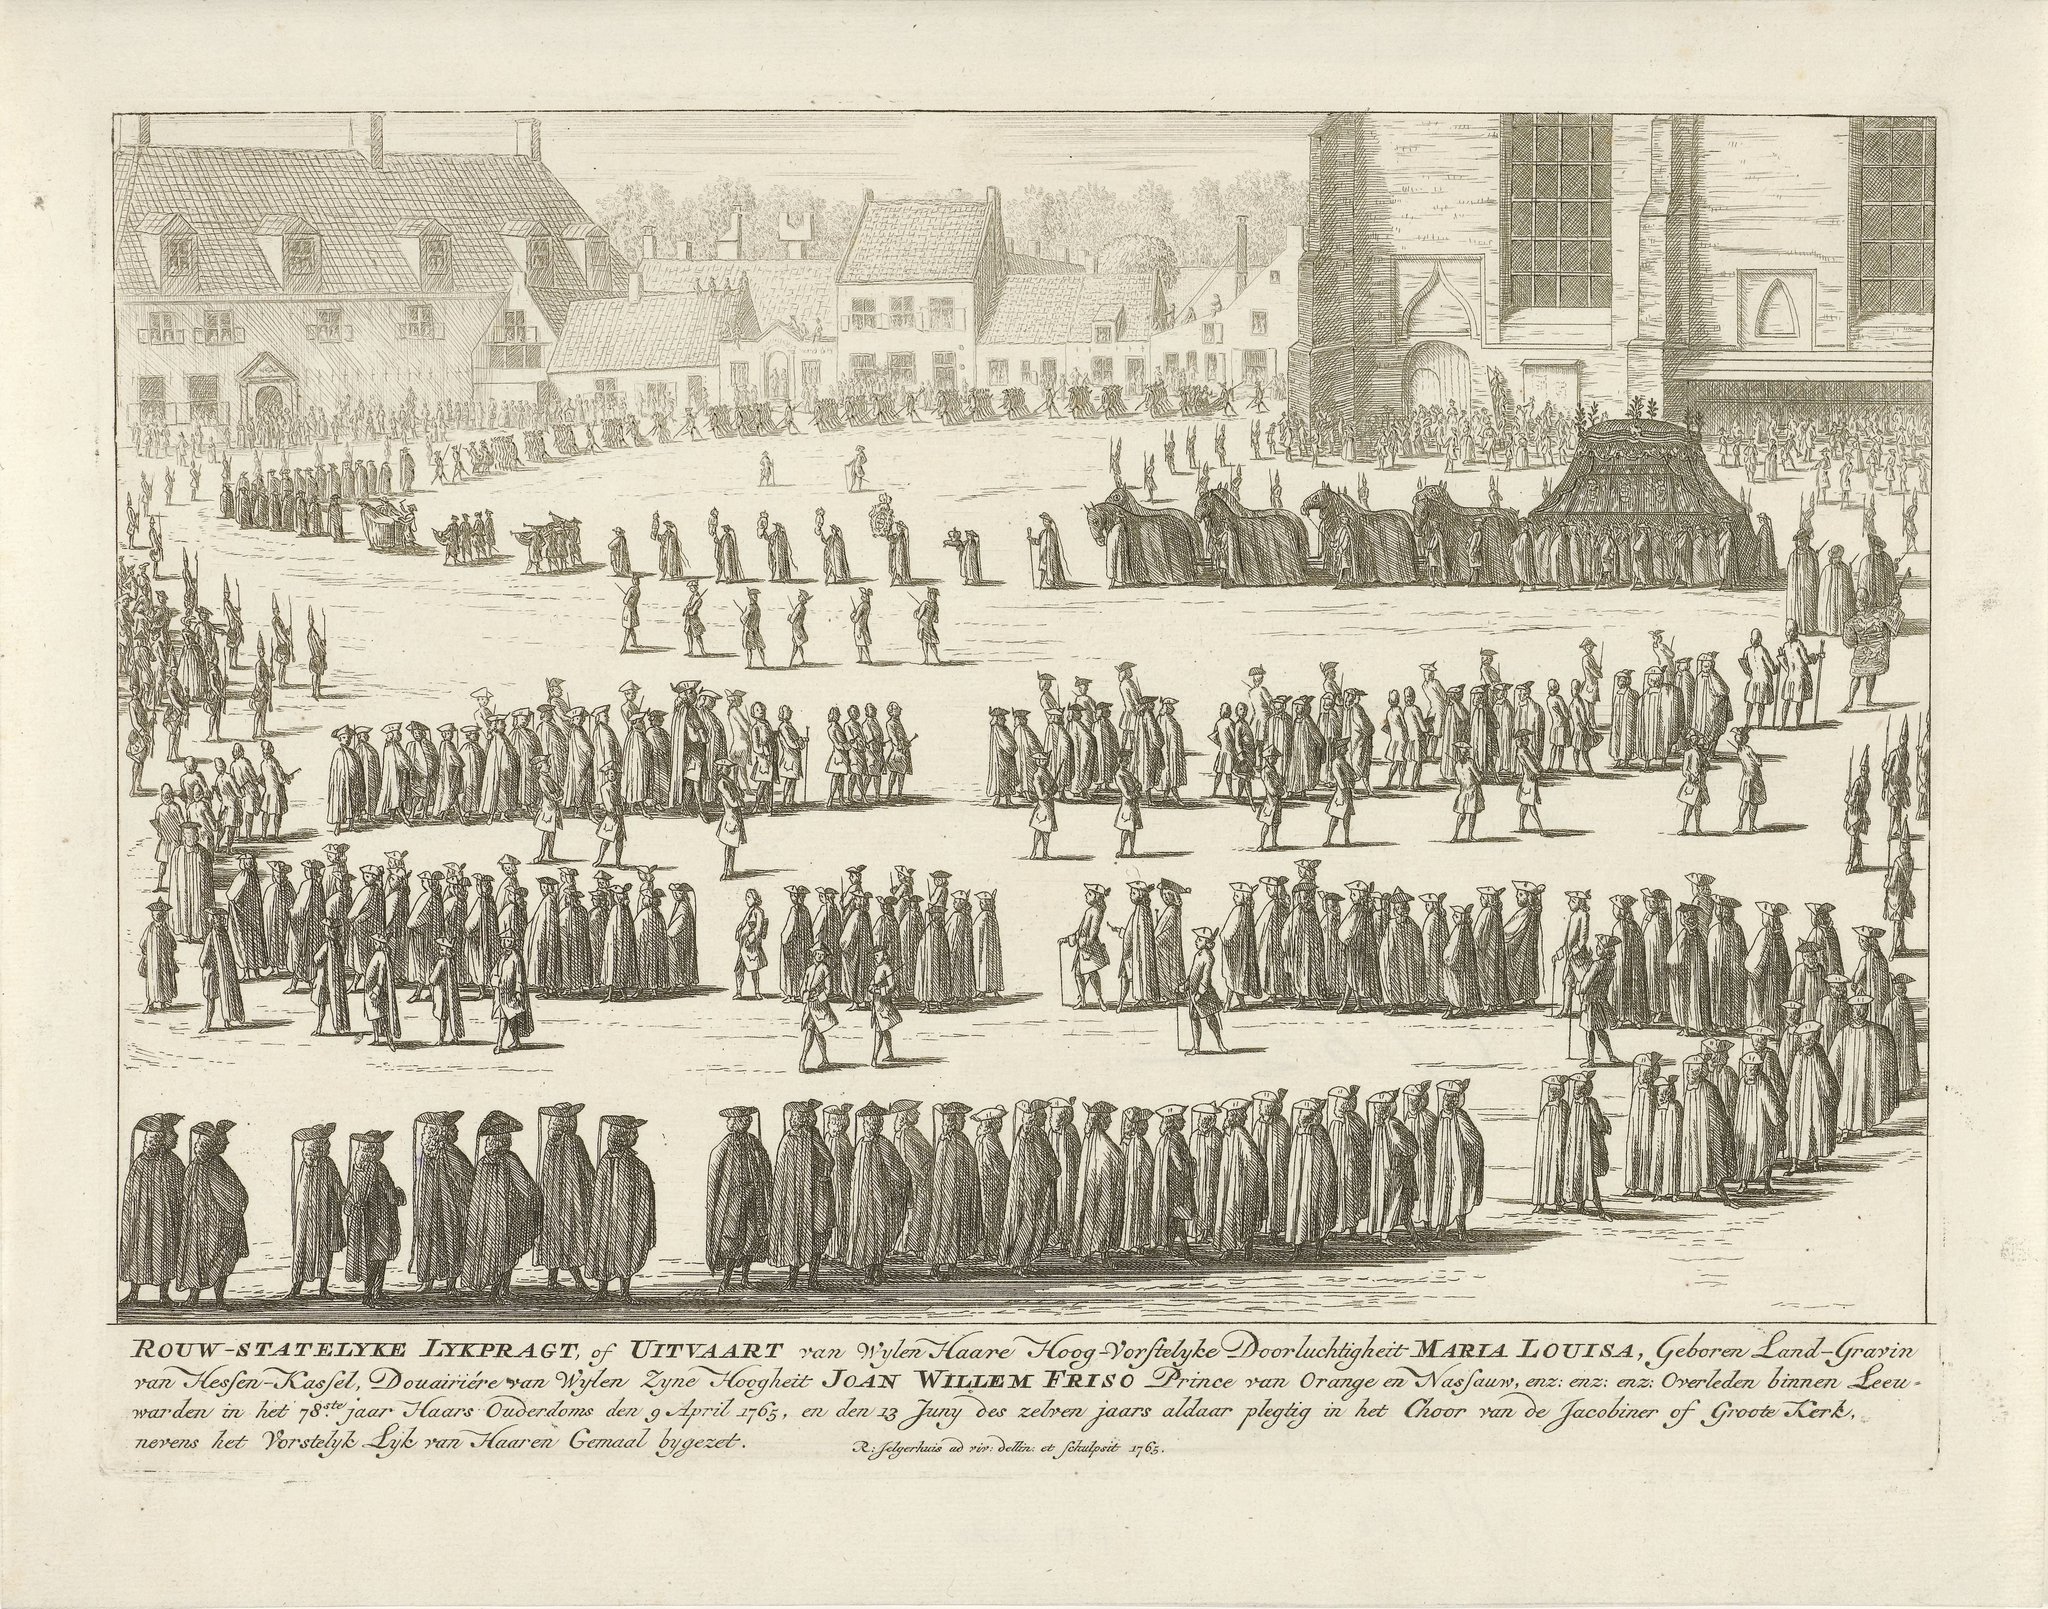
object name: print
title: Lijkstatie van Maria Louise te Leeuwarden, 1765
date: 1765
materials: paper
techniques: etching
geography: leeuwarden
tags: cortege, funeral procession, historical events and situations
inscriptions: date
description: Lijkstatie van Maria Louise, douairière van Johan Willem Friso, op 13 juni 1765 te Leeuwarden. In de marge onder de voorstelling vier regels in het Nederlands.